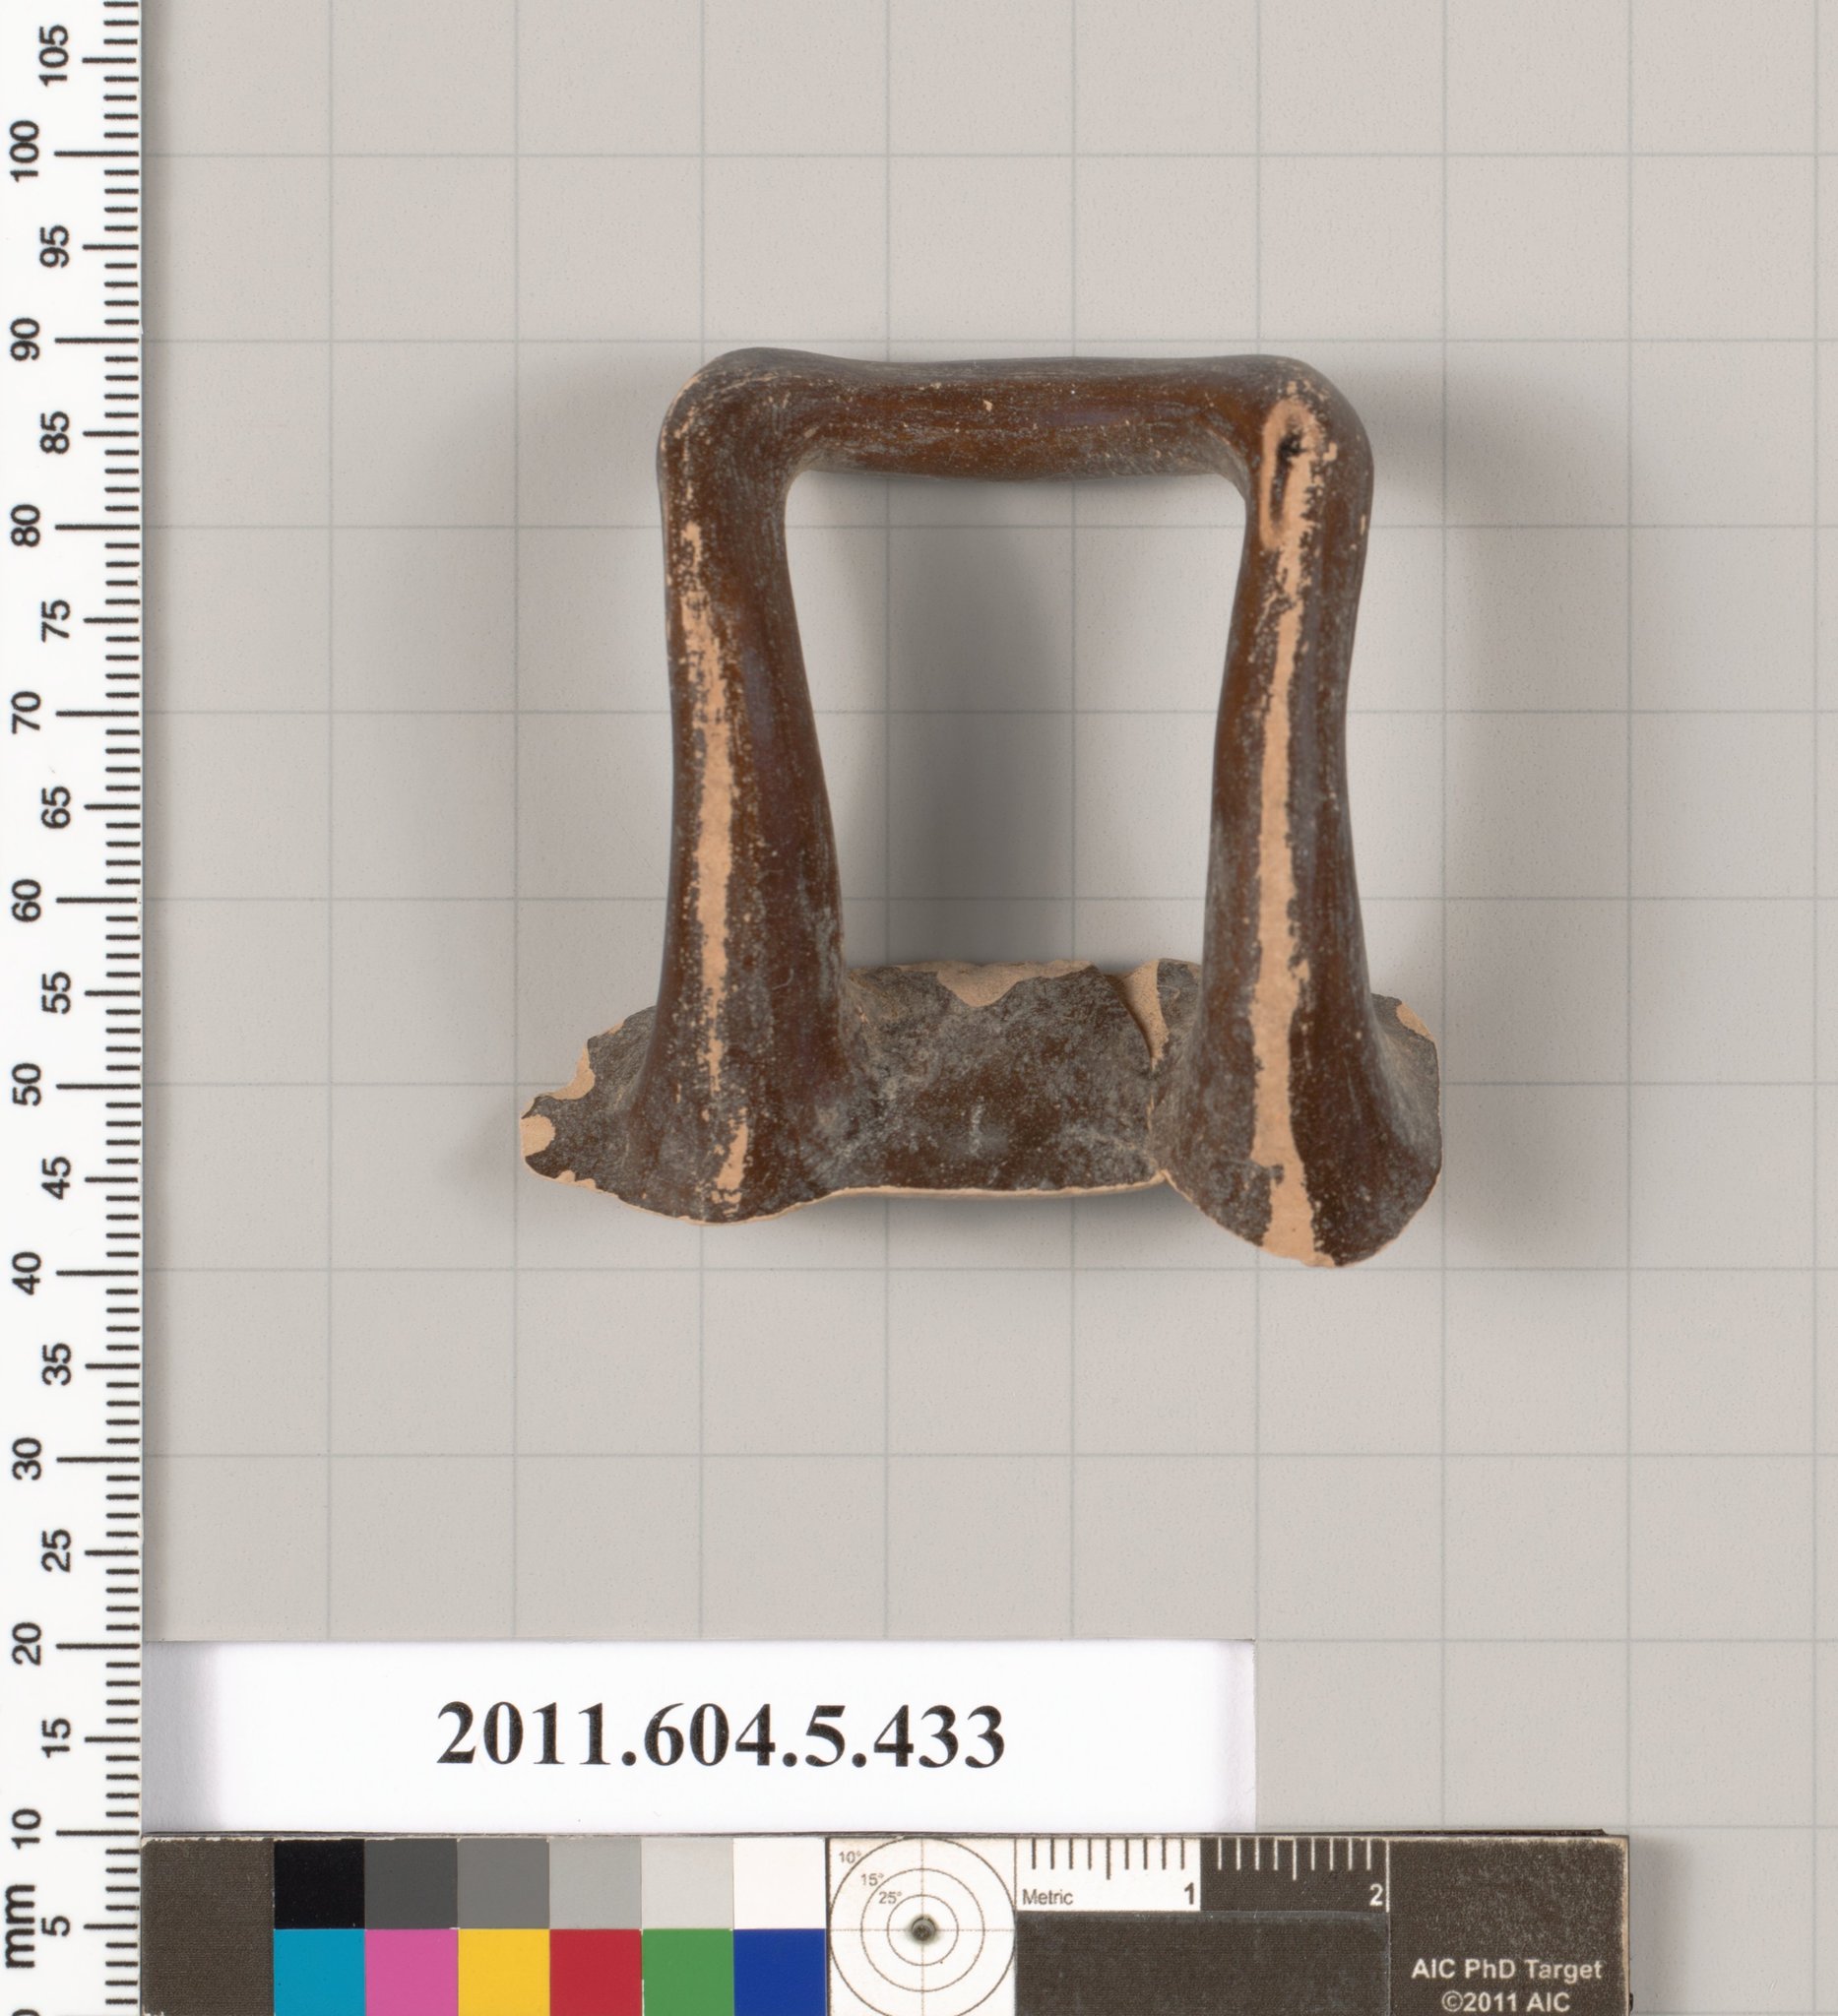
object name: kylix fragment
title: Terracotta fragment of a kylix (drinking cup)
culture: greek, attic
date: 600-401 BCE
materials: terracotta